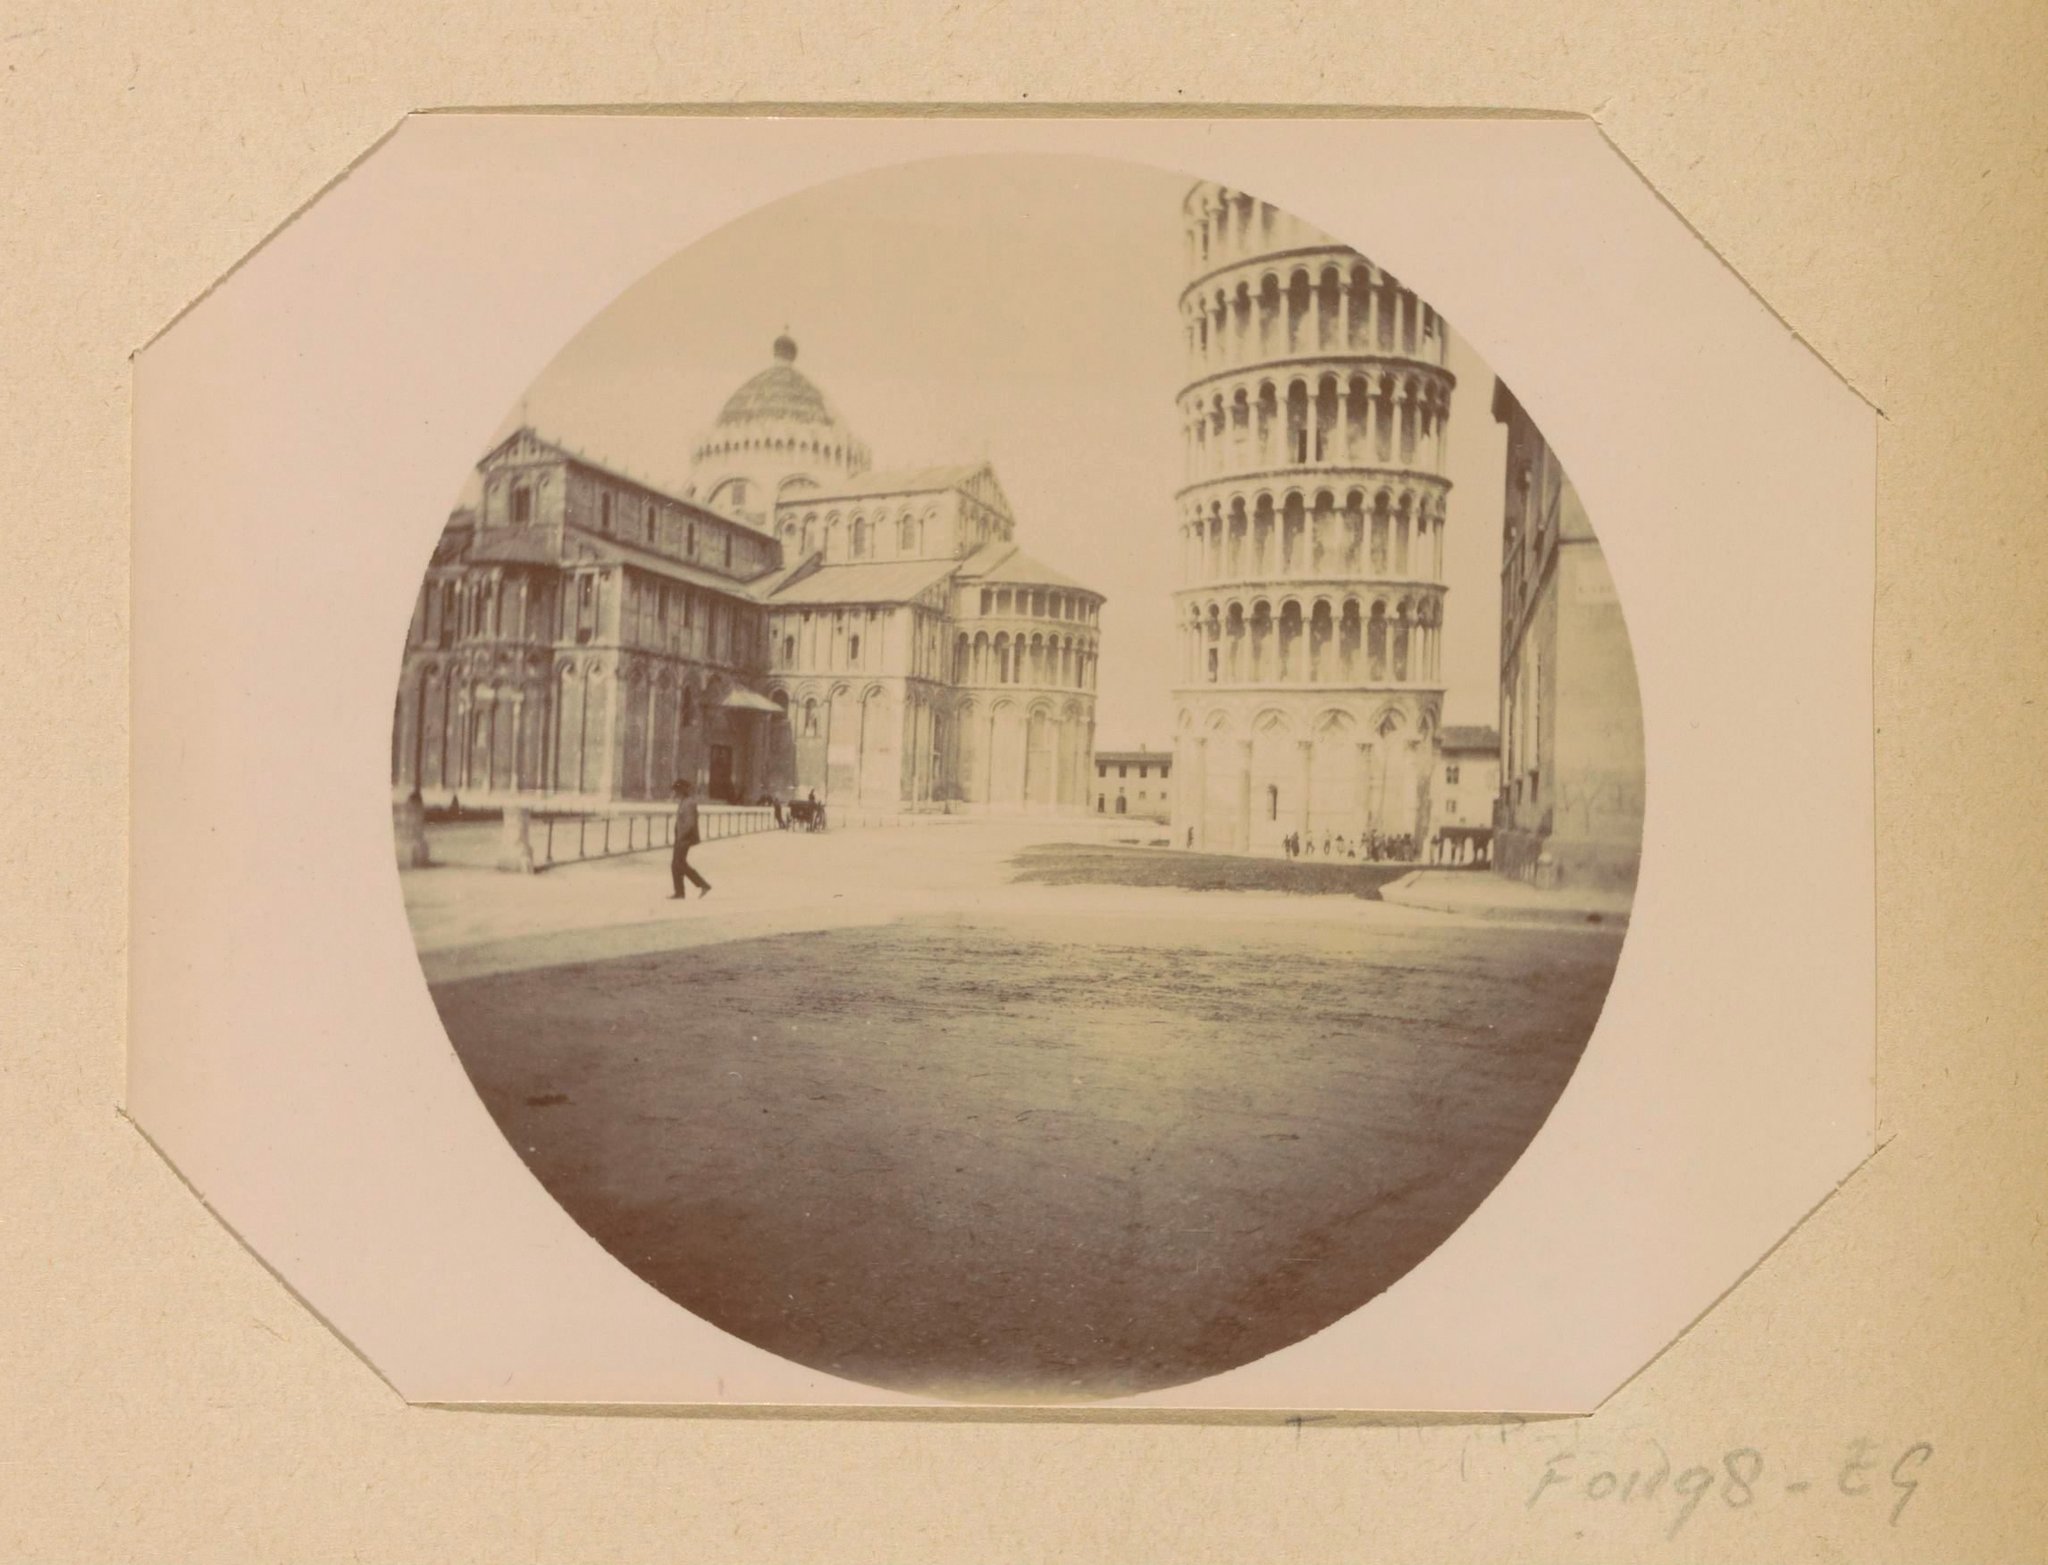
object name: album leaf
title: Pisa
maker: johanna margaretha piek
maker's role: fotograaf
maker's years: 1870-1947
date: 1889-1893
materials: paper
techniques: gelatin silver print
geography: pisa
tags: square, place, circus, etc.